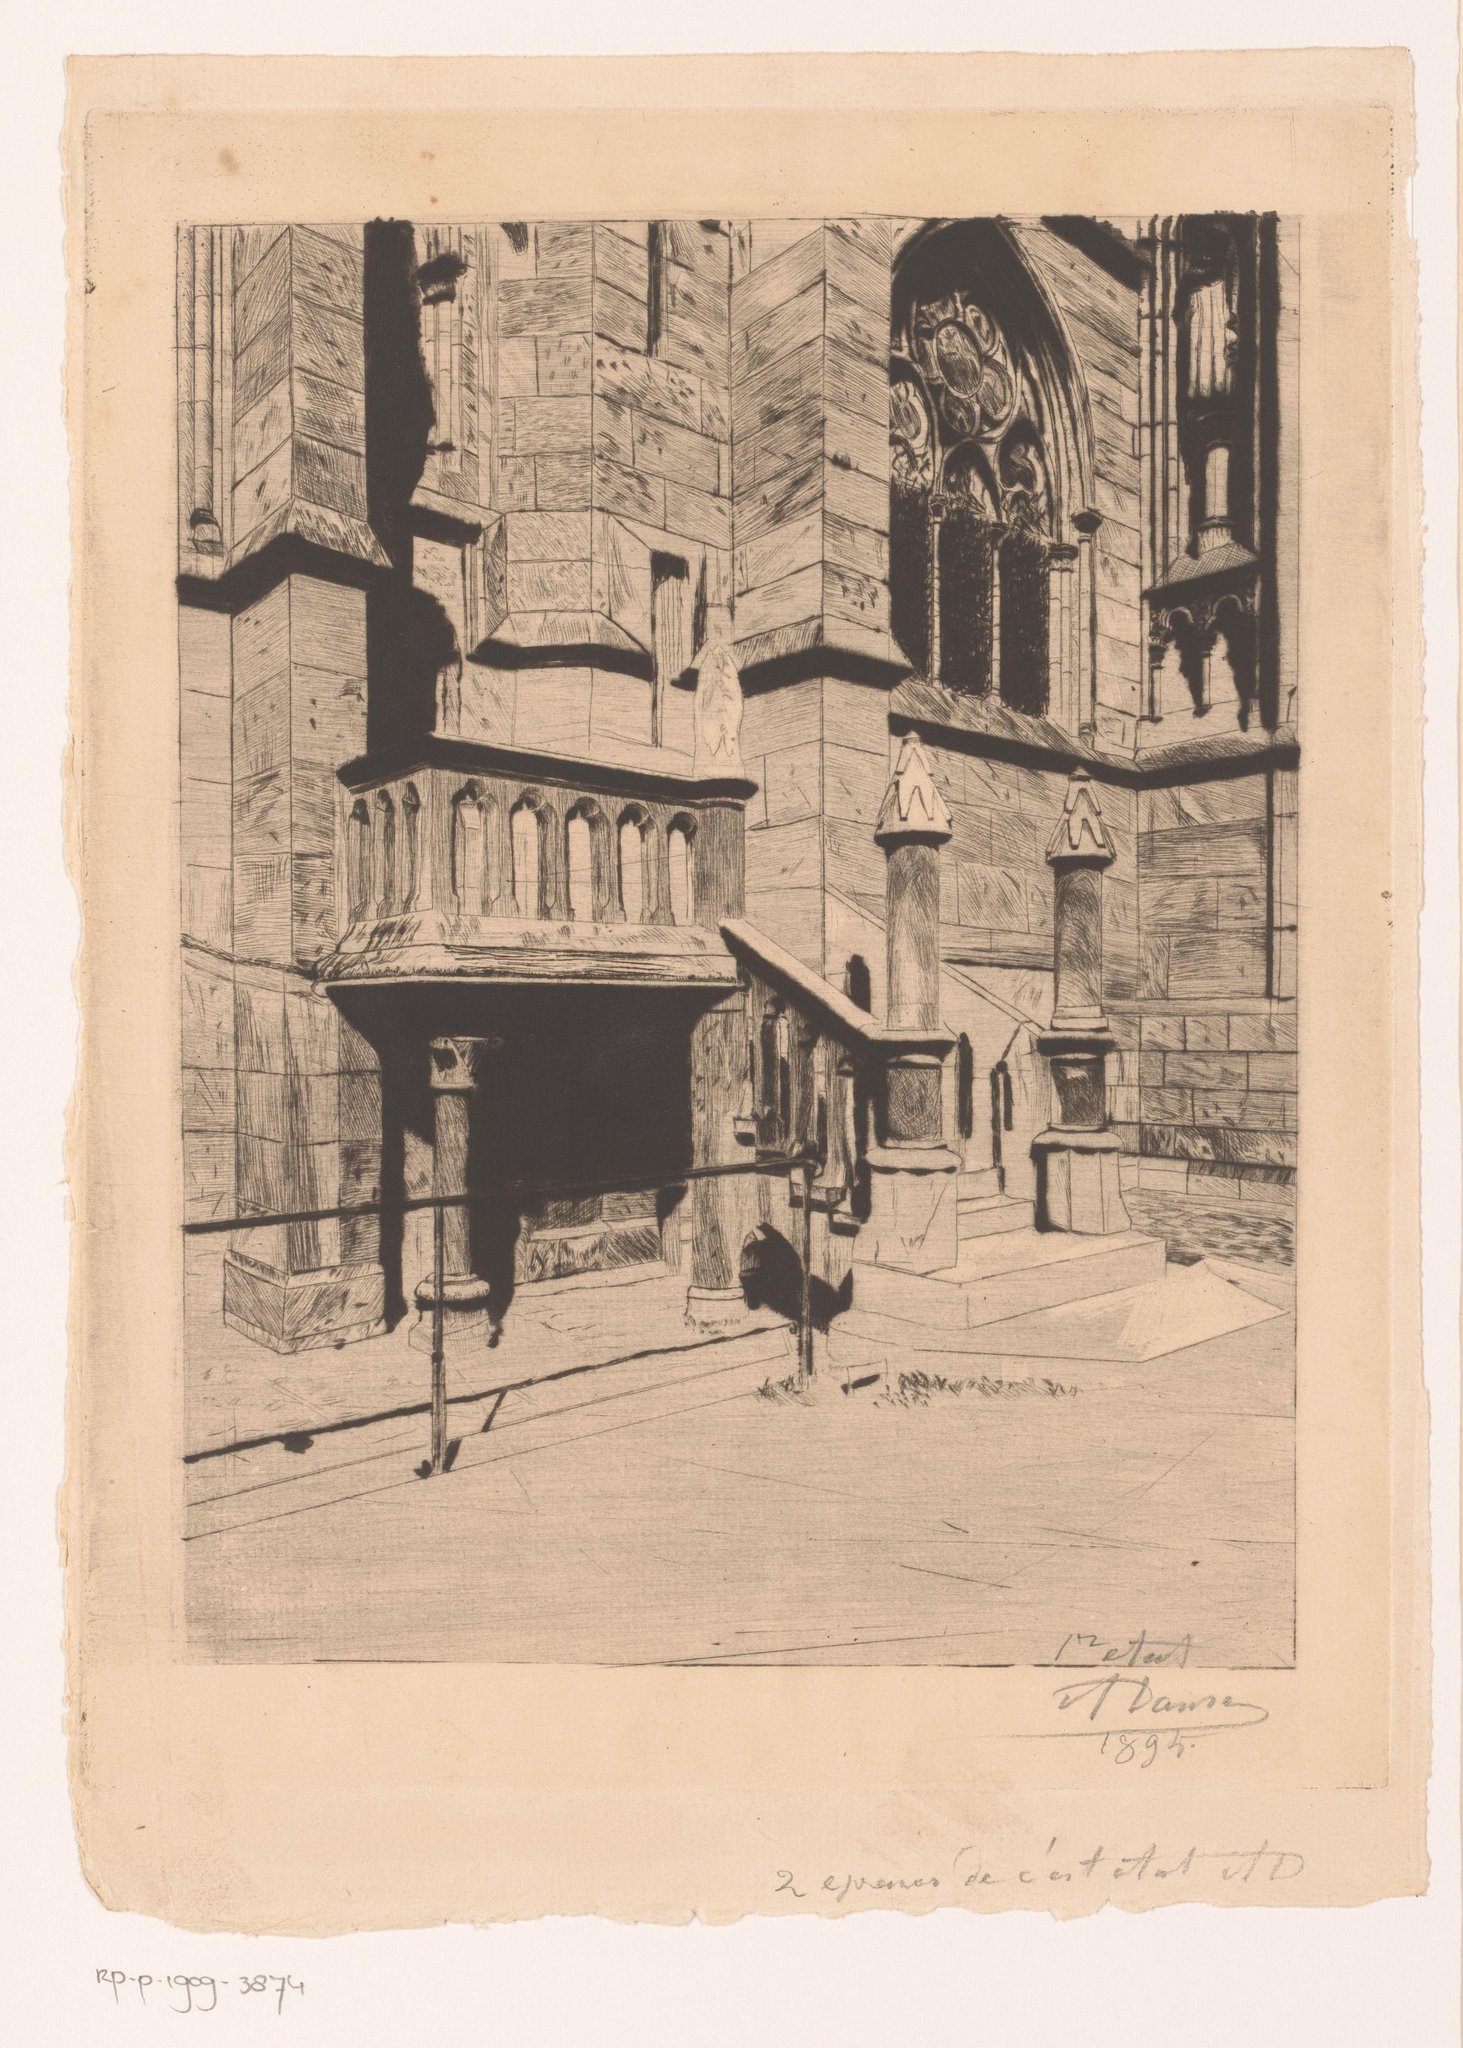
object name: print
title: Trap aan de gevel van de Notre-Dame in Parijs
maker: auguste danse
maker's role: print maker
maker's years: 1829-1929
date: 1895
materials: paper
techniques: drypoint, etching, intaglio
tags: church (exterior), paris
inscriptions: collector's mark: Lugt 2228, annotation: ‘1er etat; 2 epreuves de c'est etat’